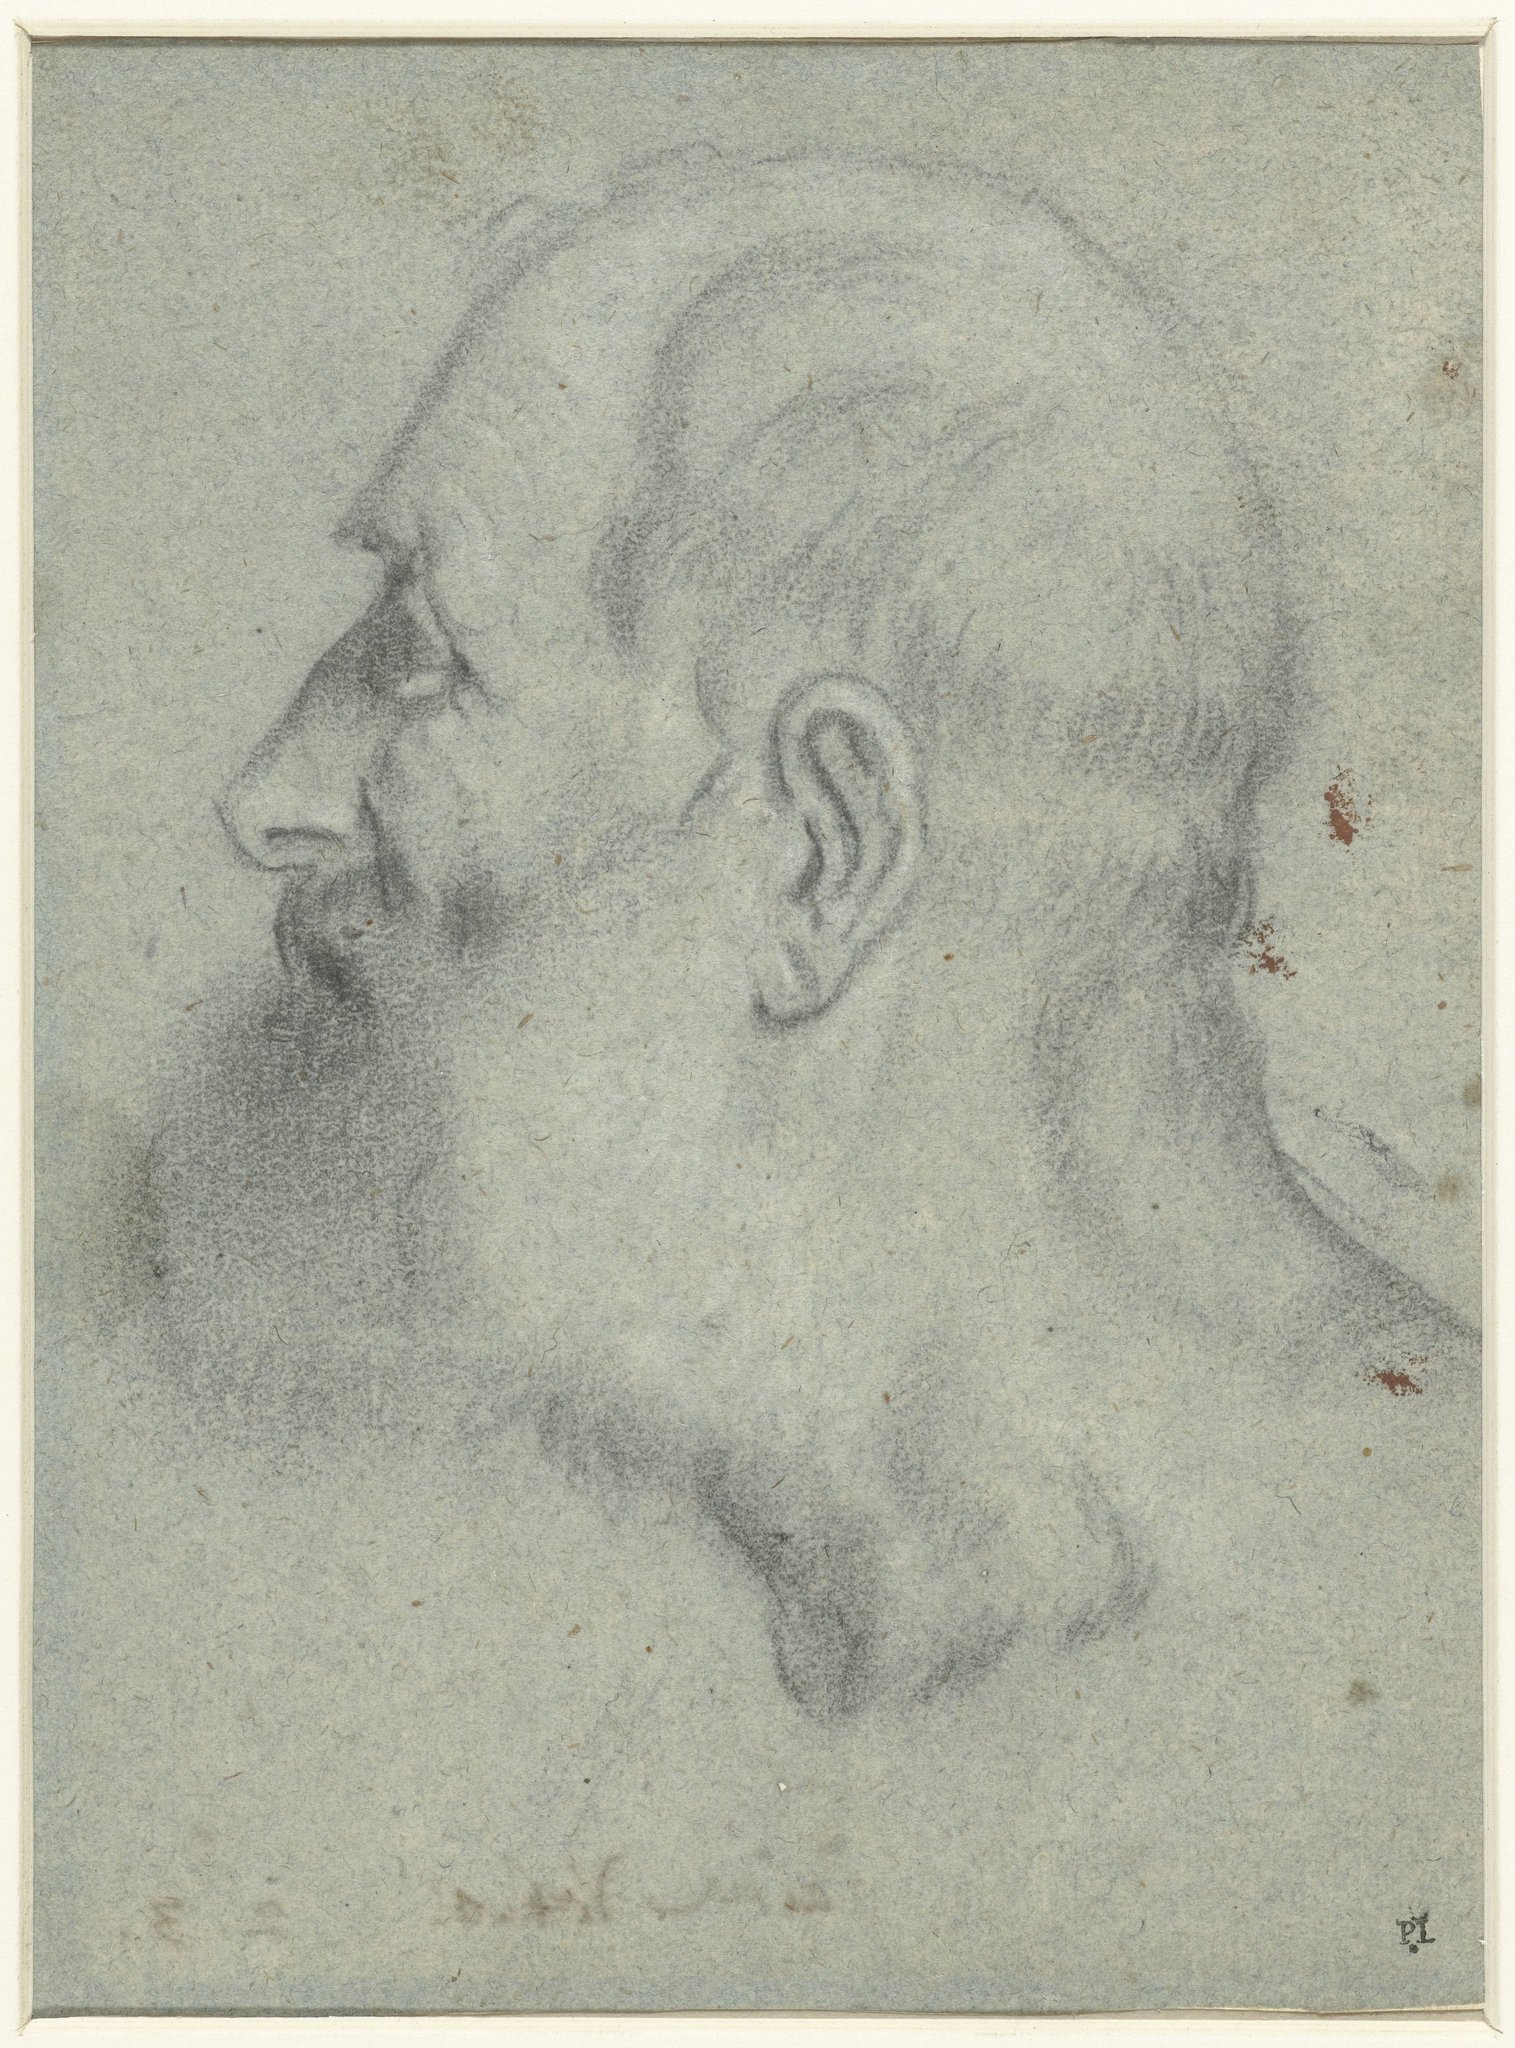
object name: drawing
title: Hoofd van man met baard, in profiel naar links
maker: bonifazio veronese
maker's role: draughtsman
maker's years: 1487-1553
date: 1500-1553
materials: chalk, paper